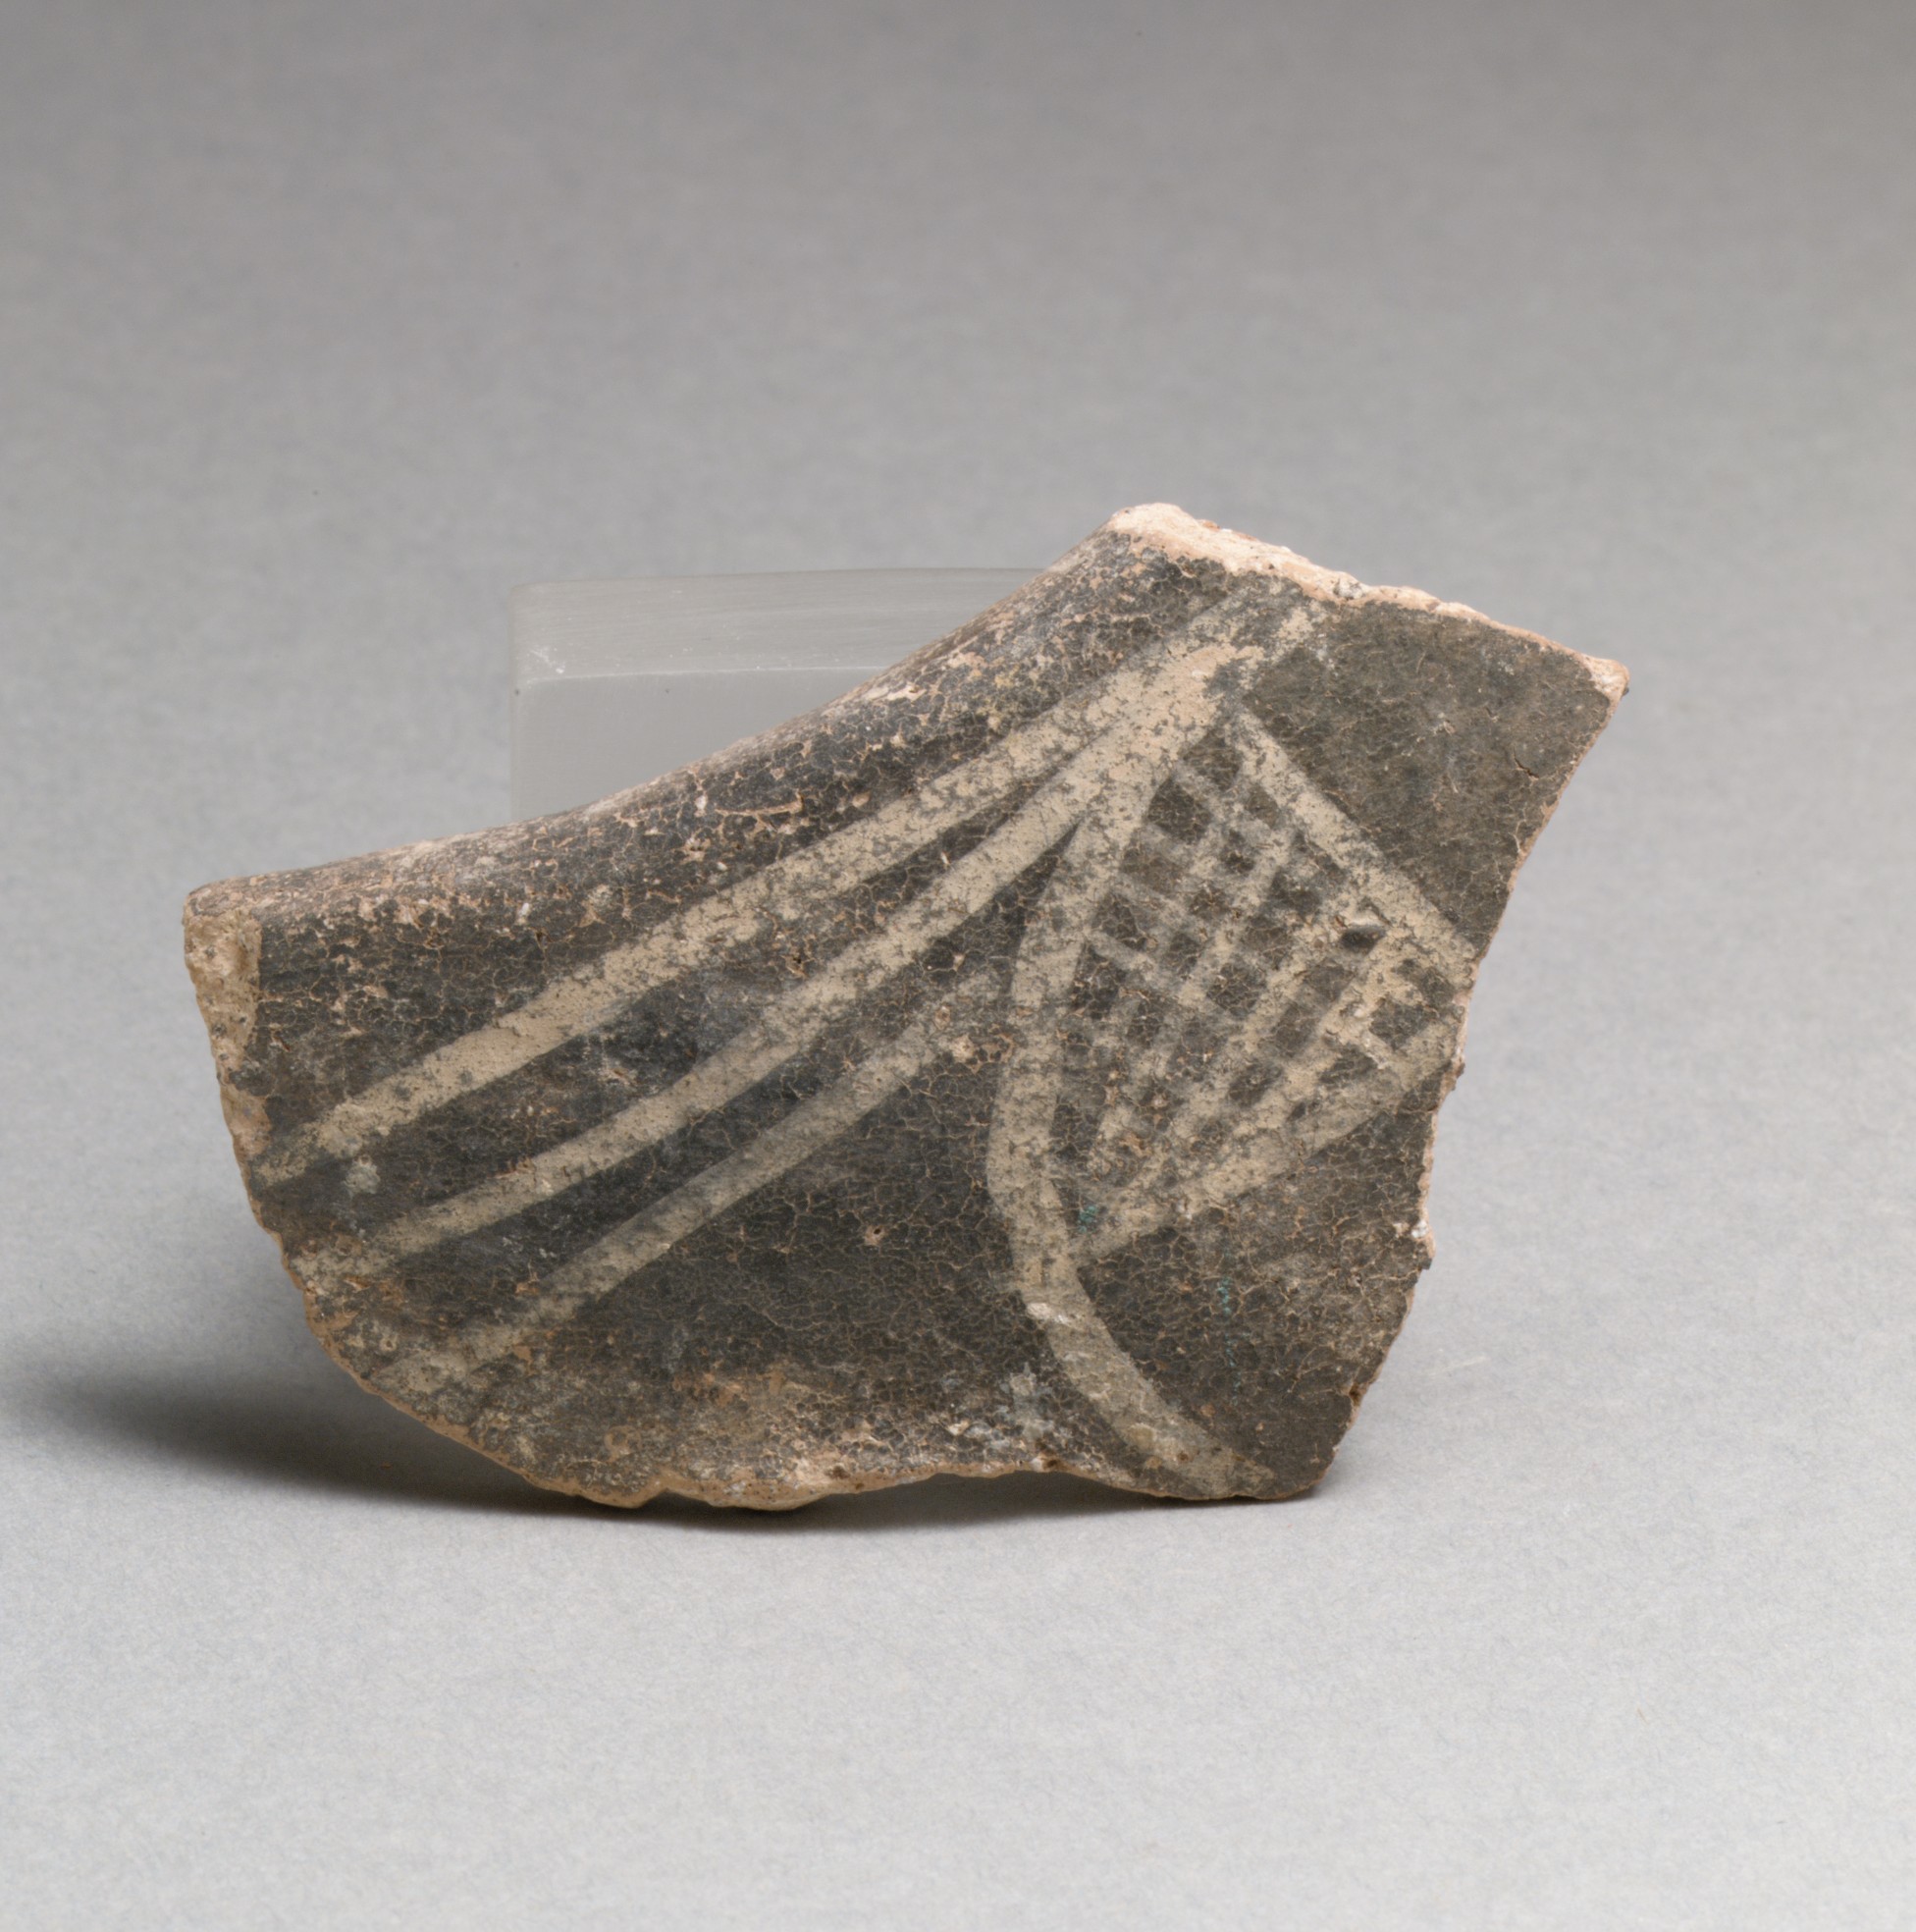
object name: vase fragment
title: Terracotta rim fragment with hatched triangle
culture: minoan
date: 2300-2100 BCE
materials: terracotta